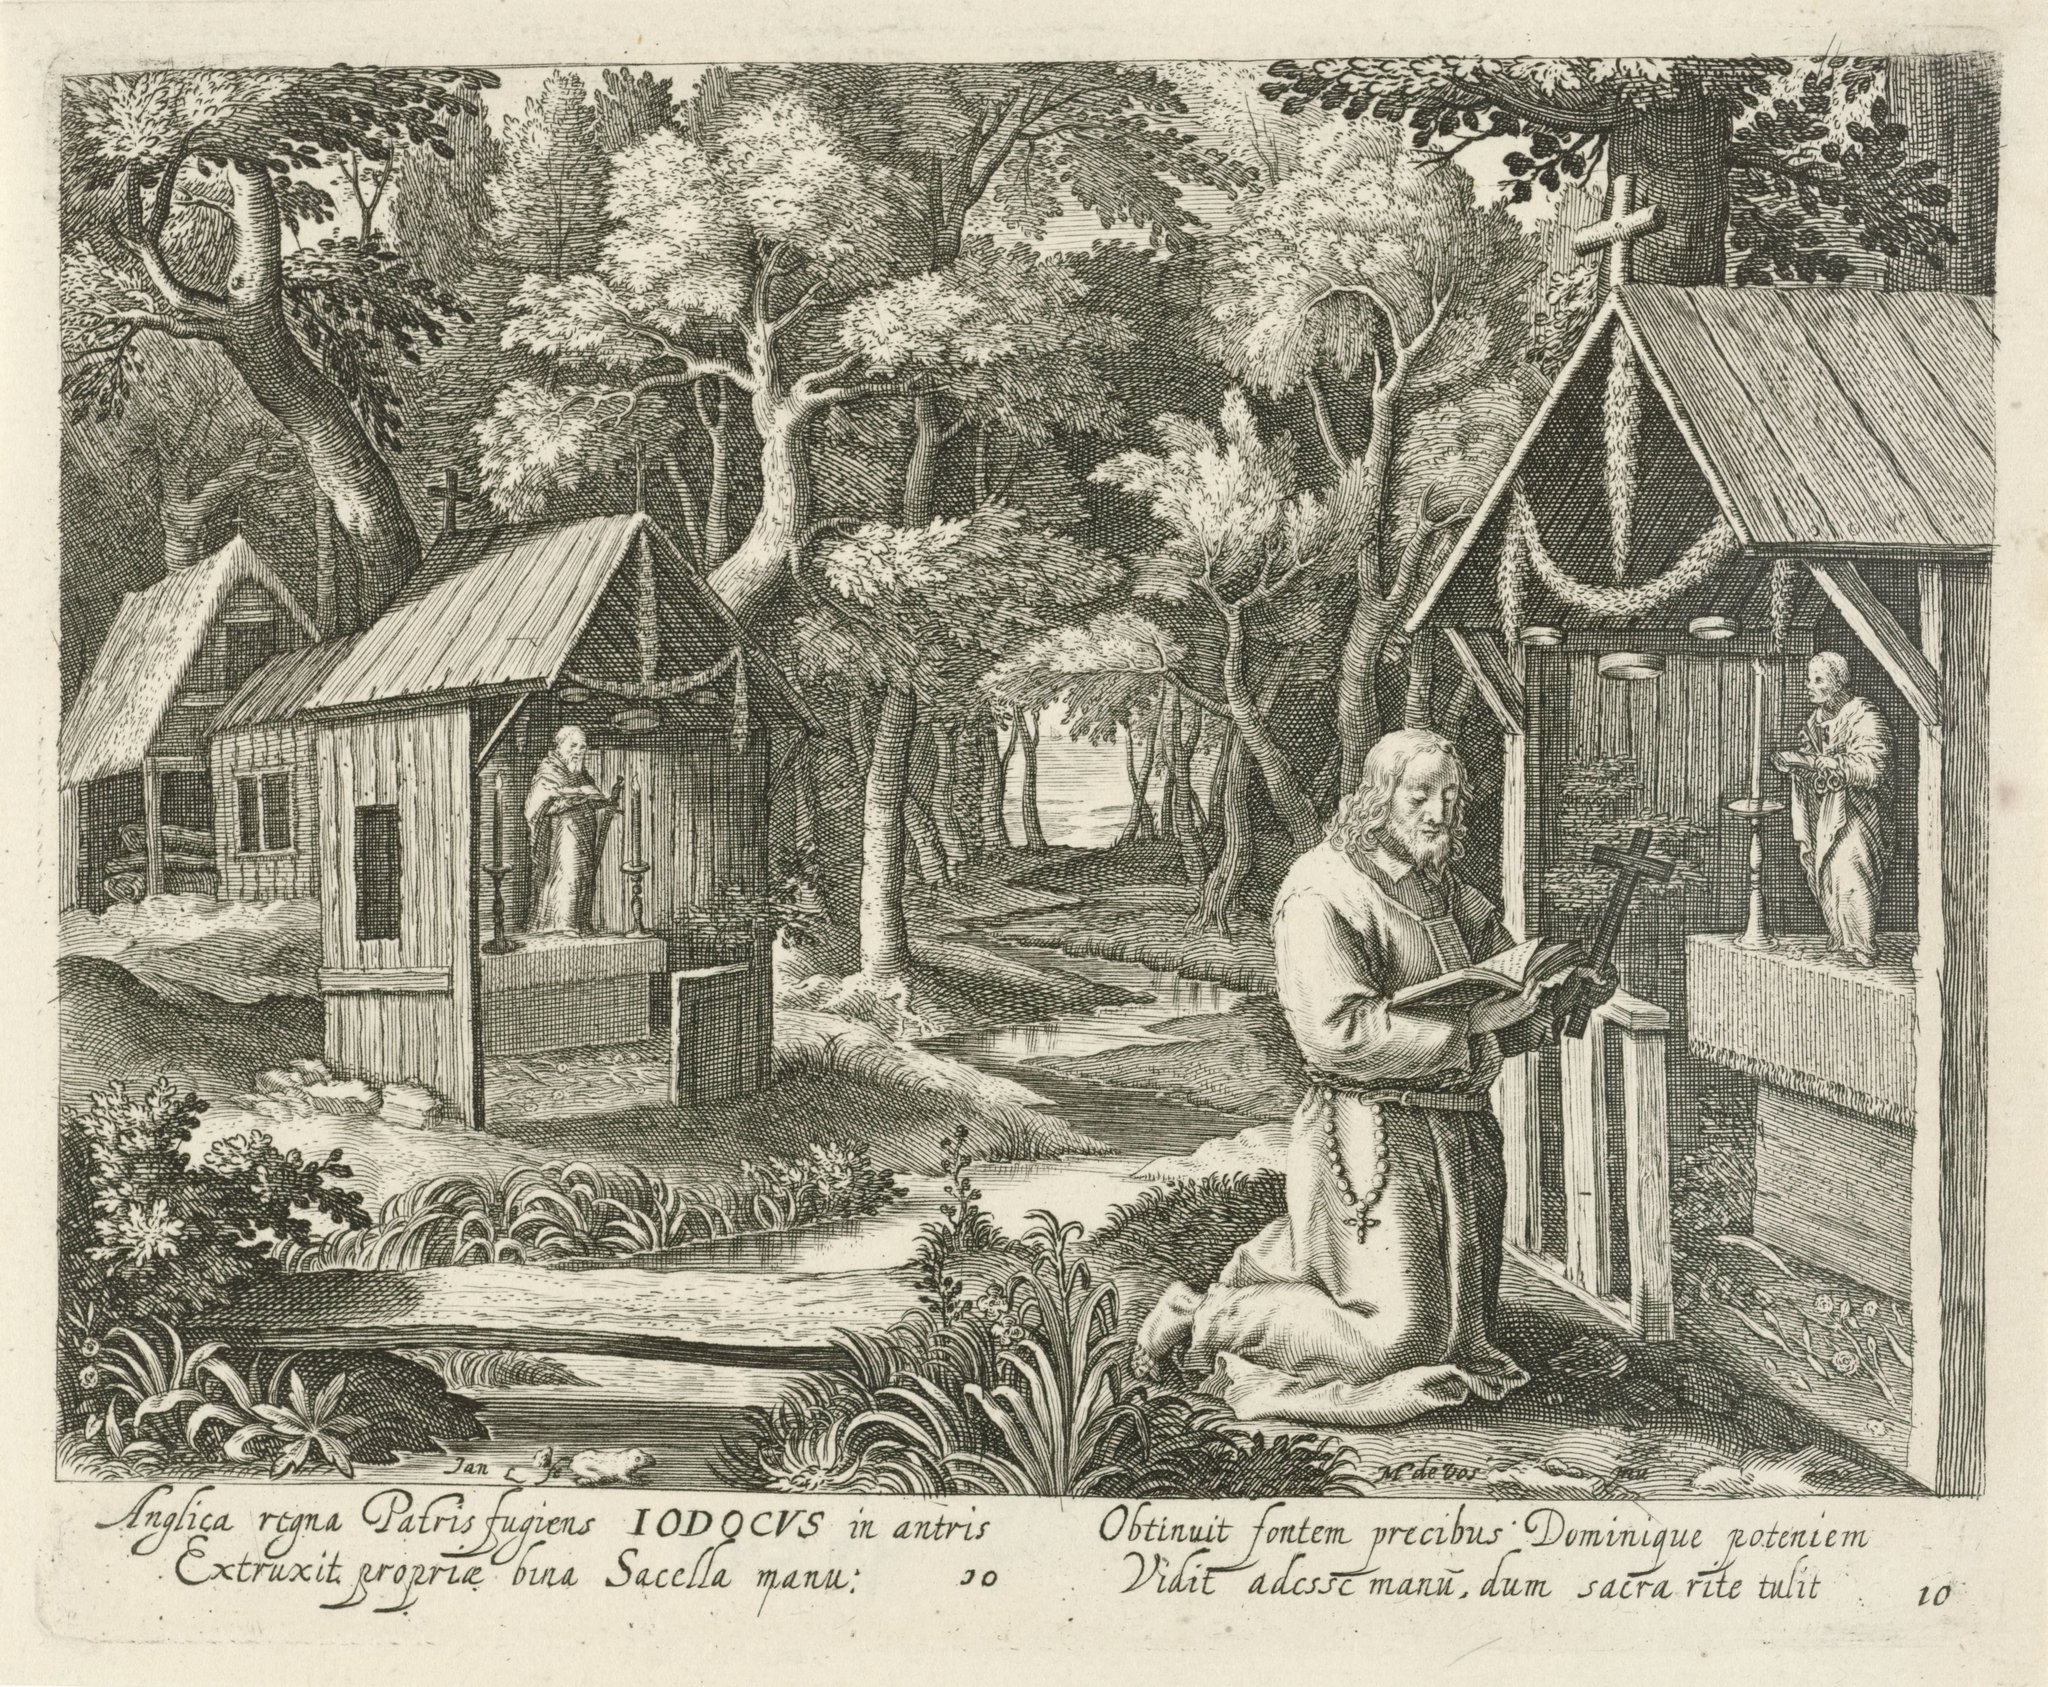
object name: print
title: H. Jodocus als kluizenaar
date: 1580-1625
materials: paper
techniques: engraving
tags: male saints (with name), forest, wood, altar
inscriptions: collector's mark: Lugt 2228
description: De heilige Jodocus is met een crucifix en een boek in zijn handen neergeknield bij een altaar in het bos. In de marge een onderschrift in Latijn.